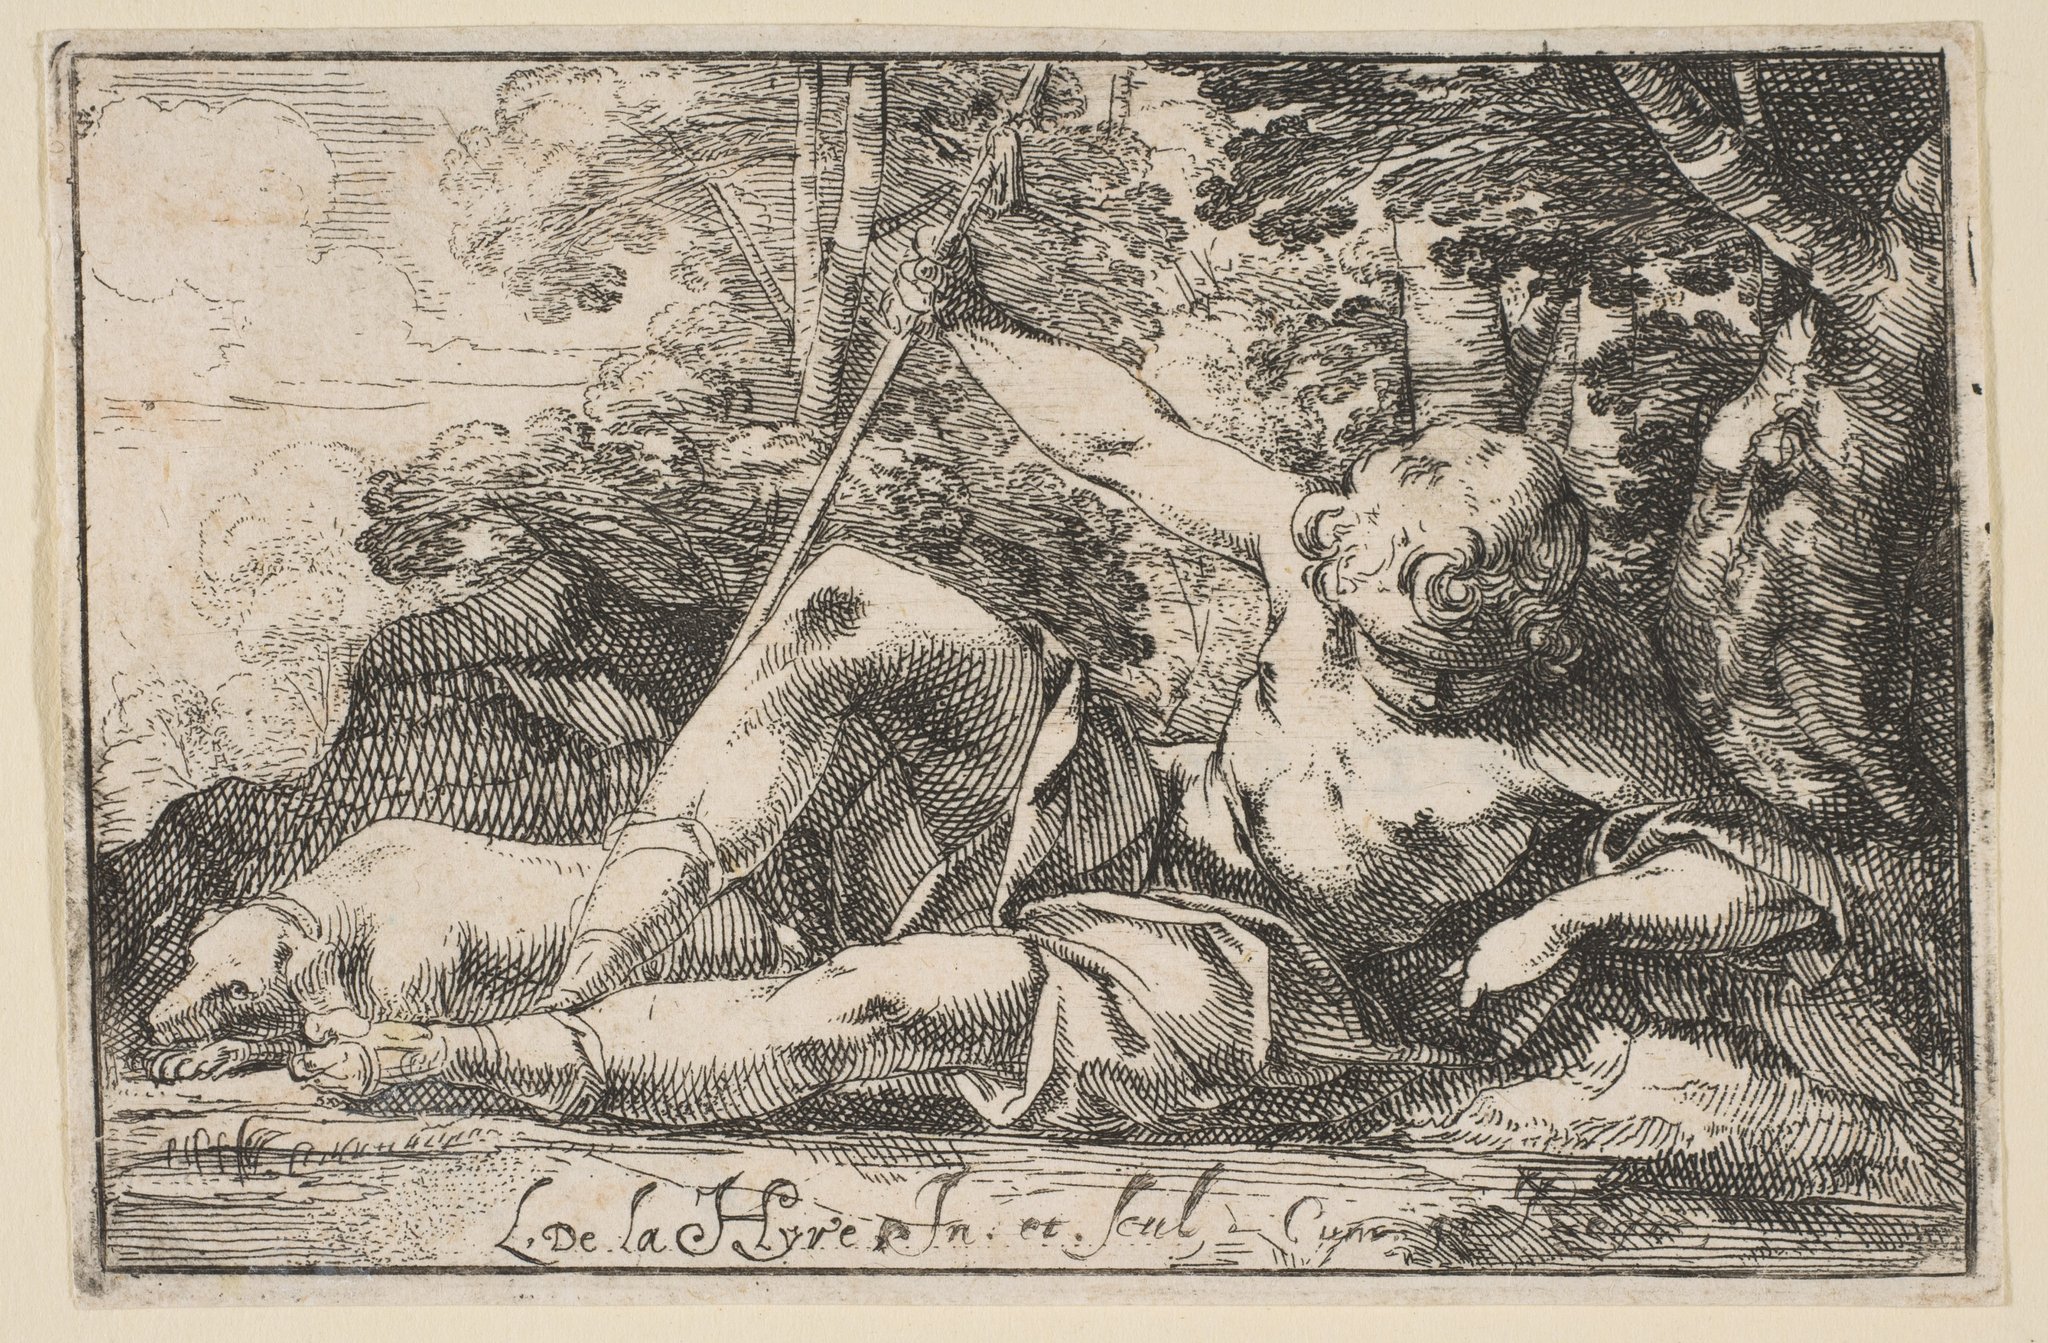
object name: print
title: Narcissus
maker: laurent de la hyre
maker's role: artist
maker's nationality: french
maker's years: 1606-1656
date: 1601-1700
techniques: etching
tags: men,dogs